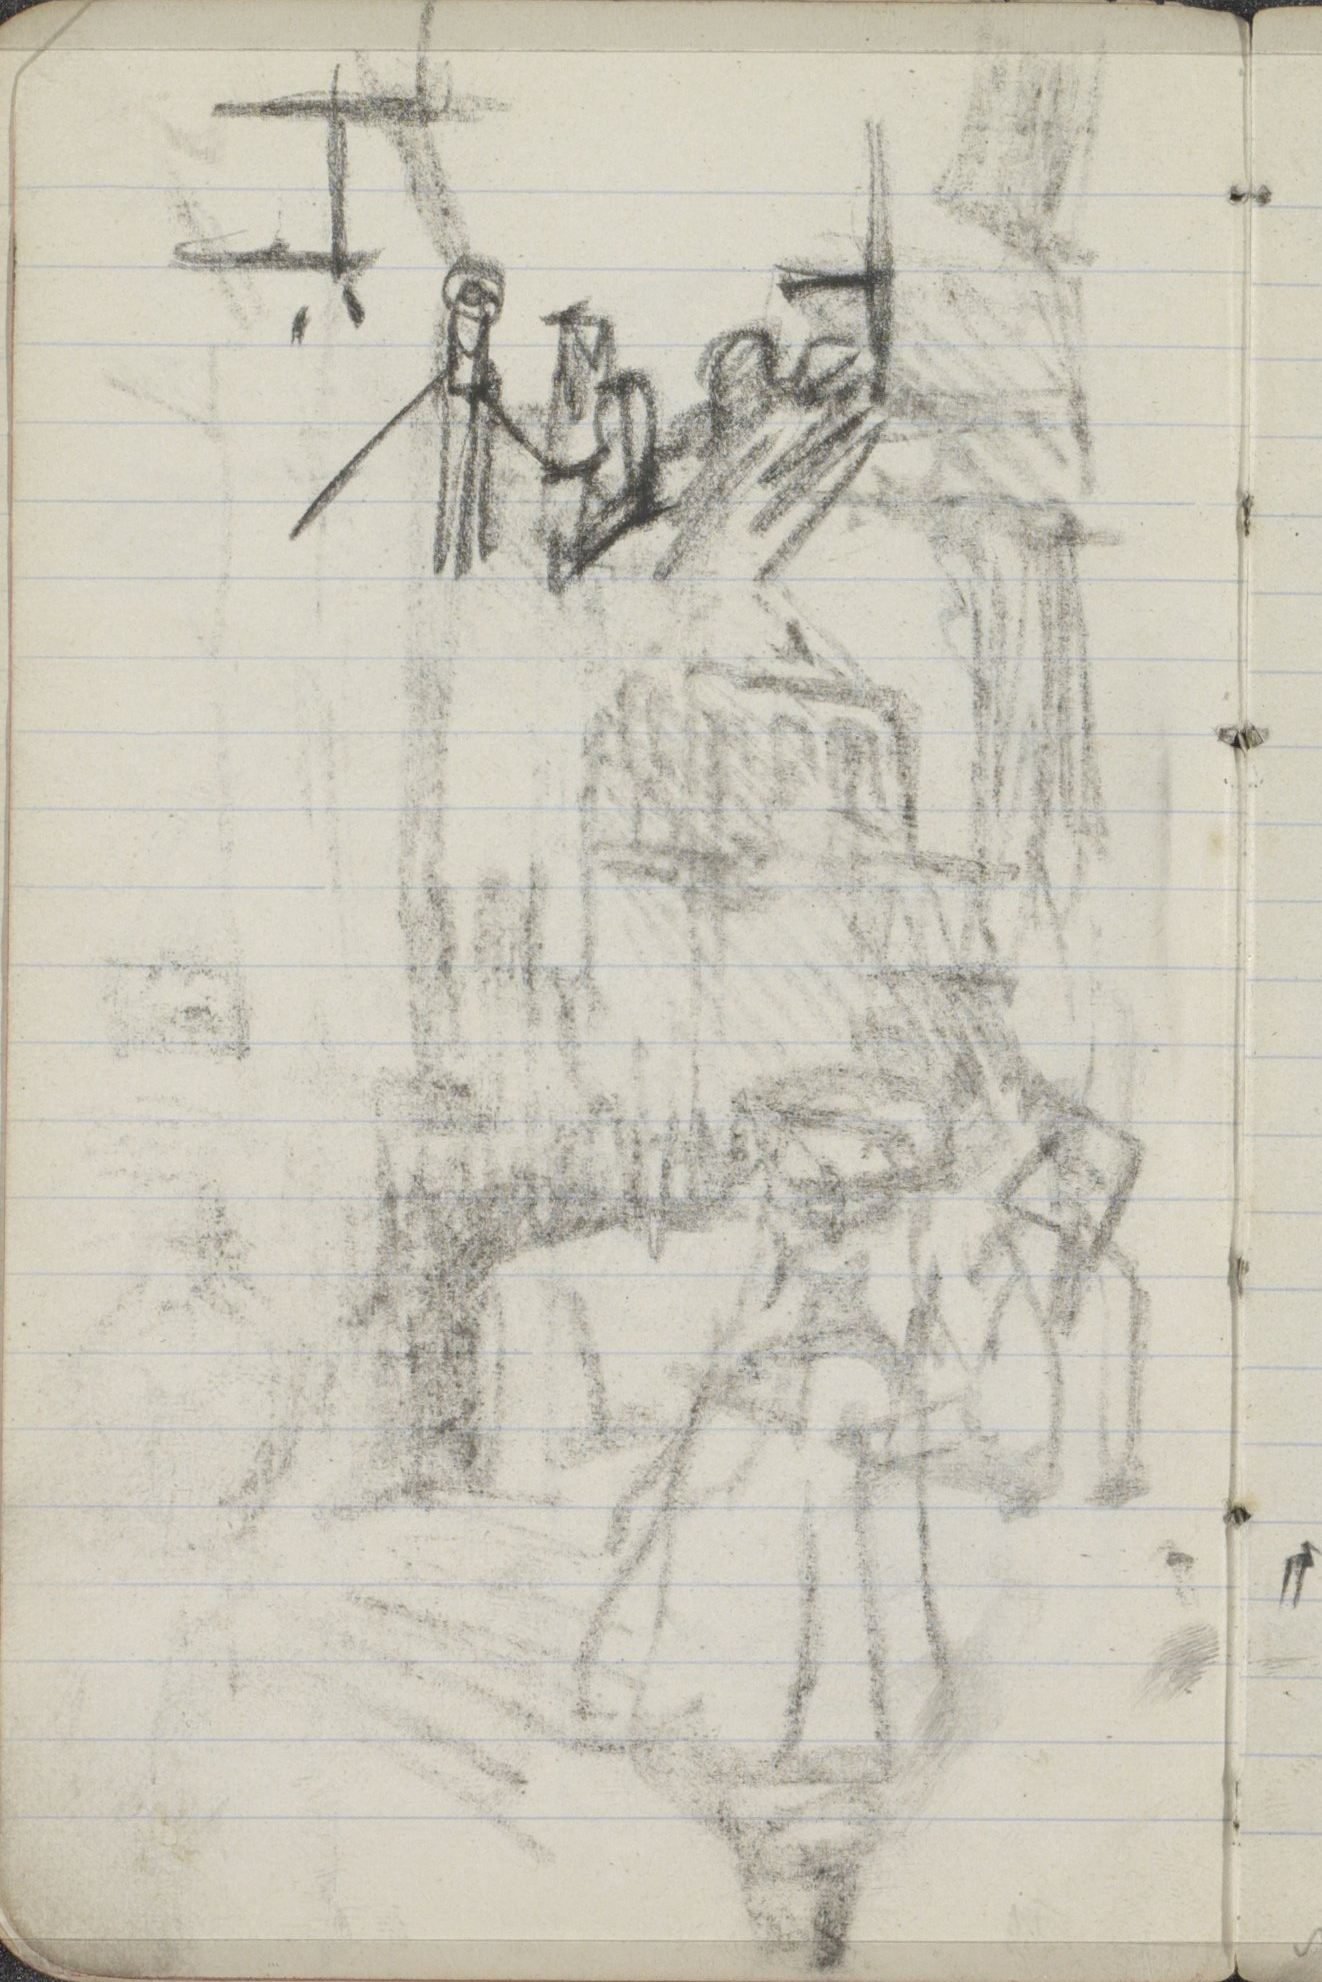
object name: sketchbook leaf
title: Daken, mogelijk van gebouwen aan de Nieuwendijk te Amsterdam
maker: george hendrik breitner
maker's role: draughtsman, painter, print maker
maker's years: 1857-1923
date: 1890-1900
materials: chalk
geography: amsterdam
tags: roof (of house or building)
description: Pagina 9 uit een schetsboek met 33 bladen.